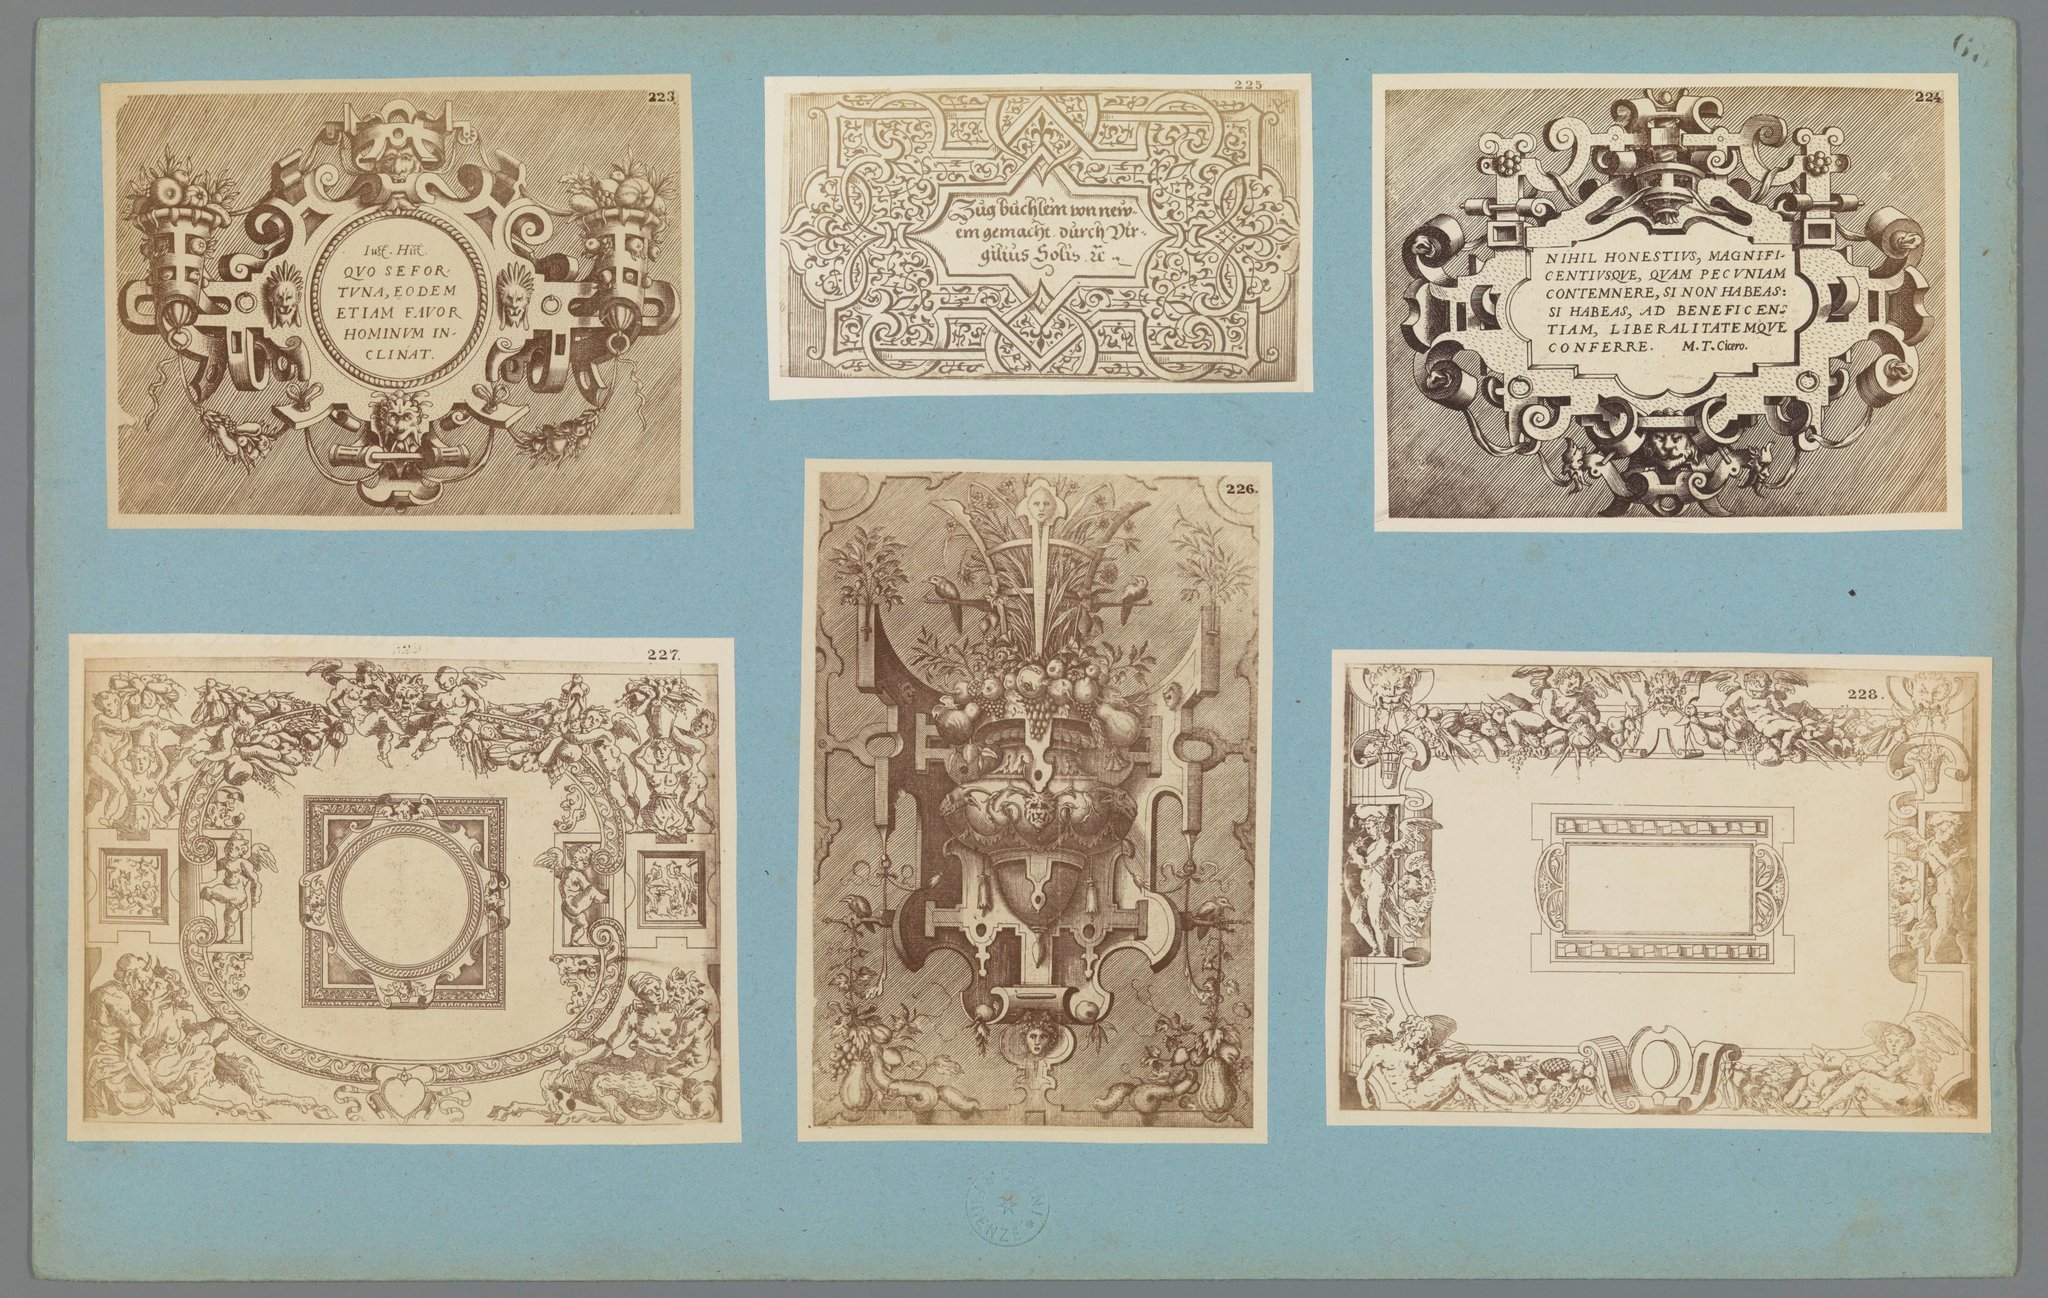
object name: photograph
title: Zes fotoreproducties van ornamentprenten met cartouches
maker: Anonymous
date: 1875-1900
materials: cardboard, photographic support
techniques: albumen print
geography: europe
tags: fruits and vegetables ~ ornament, scrollwork, strapwork ~ ornament, satyr(s) (in general), ornament ~ cartouche, europe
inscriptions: number: ‘223.’, number: ‘226.’, number: ‘68’, number: ‘228.’, collector's mark: Lugt 3937, number: ‘224’, name: ‘C. PINI FIRENZE’, number: ‘225’, number: ‘227.’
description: Linksboven (223) een prent van Latijnse tekst in een cartouche met rolwerk en fruitmanden, linksonder (227) een prent van een cartouche omringd door saters en putti, middenboven (225) een prent van Duitse tekst in een cartouche met abstracte patronen, middenonder (226) een prent van rolwerk en vruchten, rechtsboven (224) een prent van Latijnse tekst in een cartouche met rolwerk, rechtsonder (228) een prent van een cartouche omringd door gevleugelde figuren.